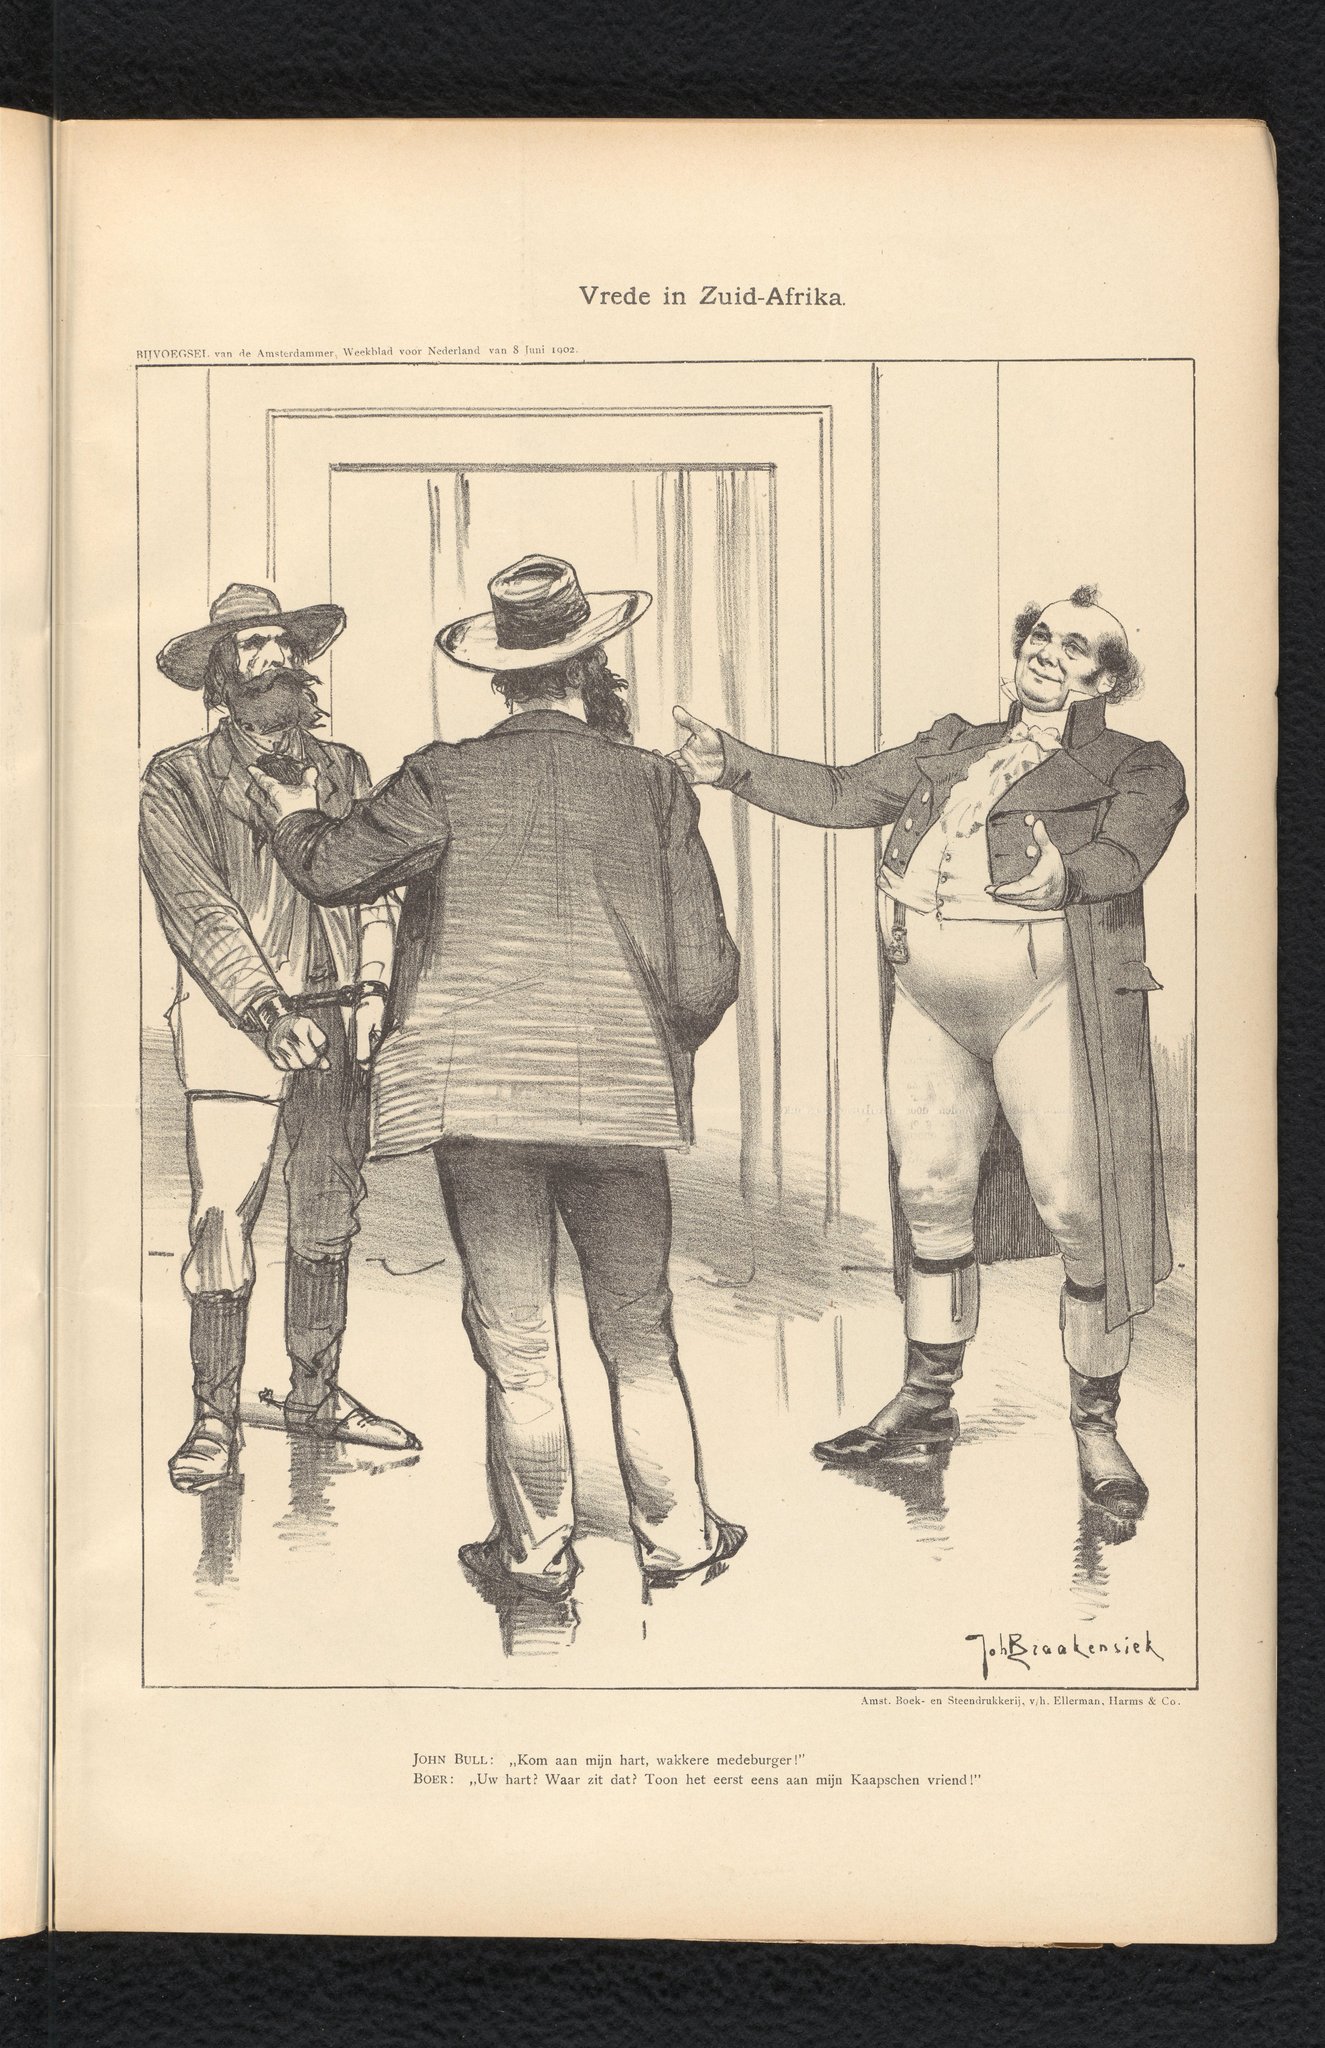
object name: cartoon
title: Vrede in Zuid-Afrika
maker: johan braakensiek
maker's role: draughtsman, print maker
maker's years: 1858-1940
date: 1902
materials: paper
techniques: lithograph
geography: netherlands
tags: personifications of countries, nations, states, districts, etc., signing of peace treaty, concluding the peace, political caricatures and satires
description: John Bull (Engeland) wil de Boeren in zijn armen sluiten. Een Boer uit de Kaapprovincie is echter nog geboeid. Naar aanleiding van de Vrede van Vereeniging gesloten op 31 mei.